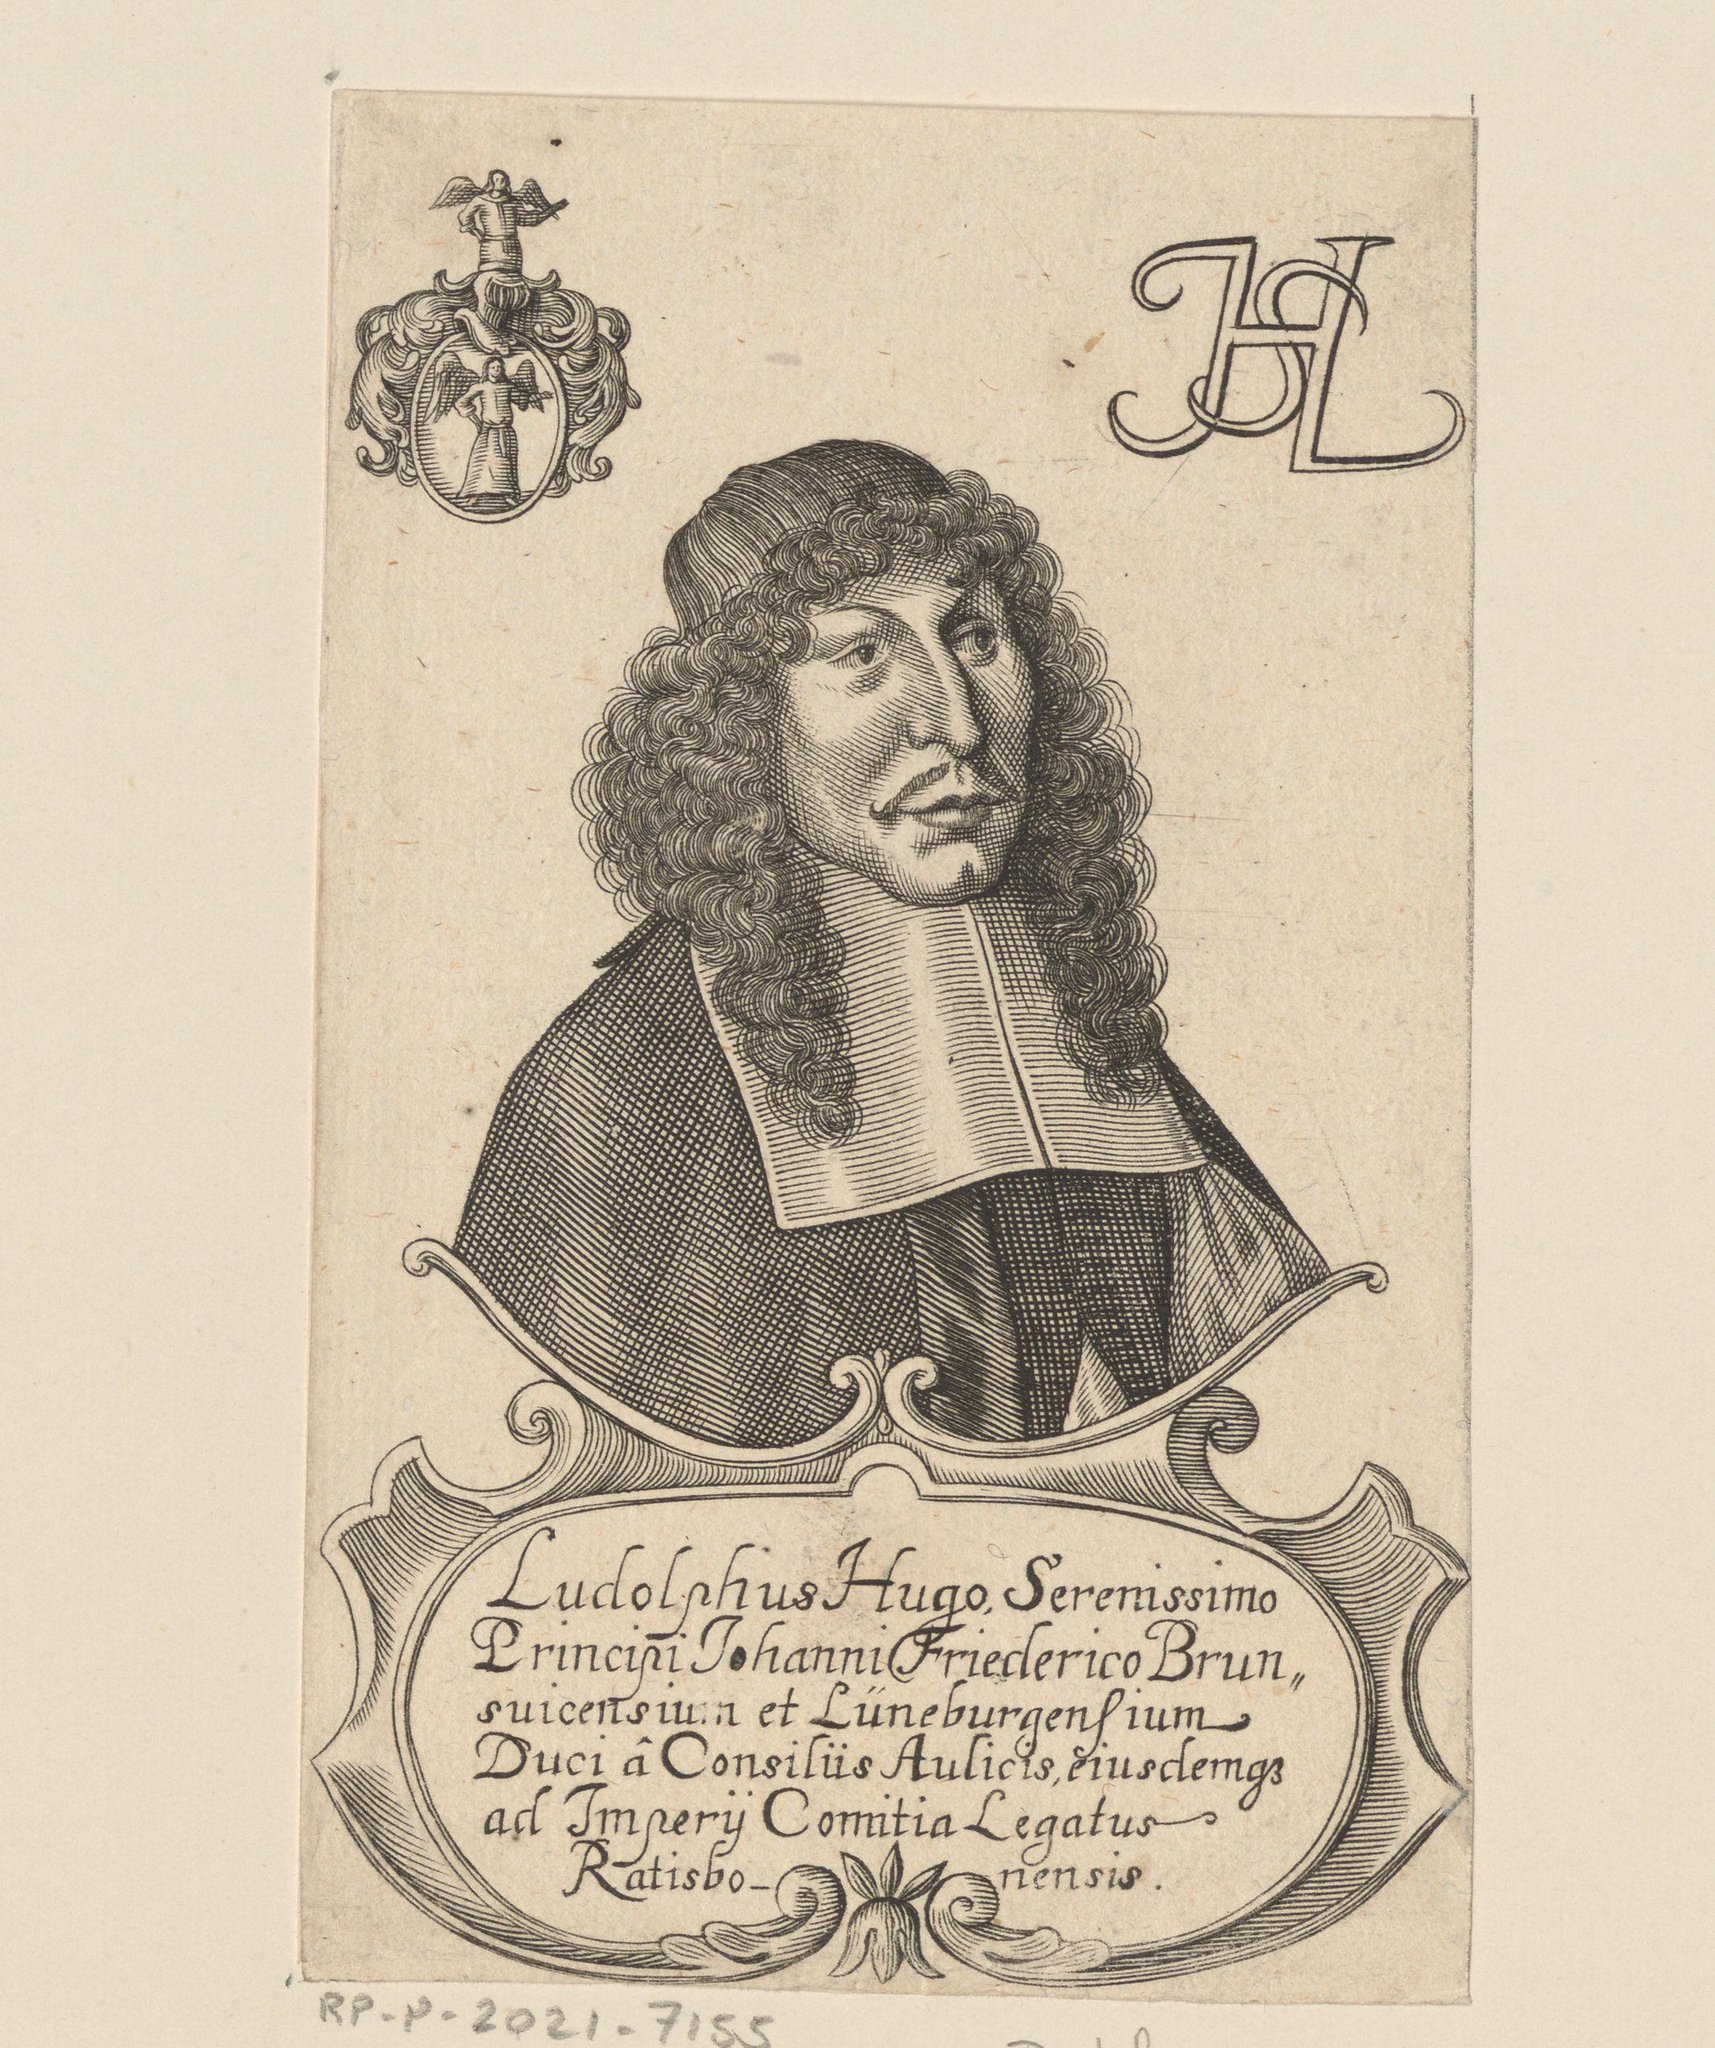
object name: print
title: Portret van Ludolf Hugo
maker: Anonymous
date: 1700-1749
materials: paper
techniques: engraving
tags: politician, magic mathematical figures; magic numbers, words, monograms, historical persons, politician, e.g. party leader, armorial bearing, heraldry